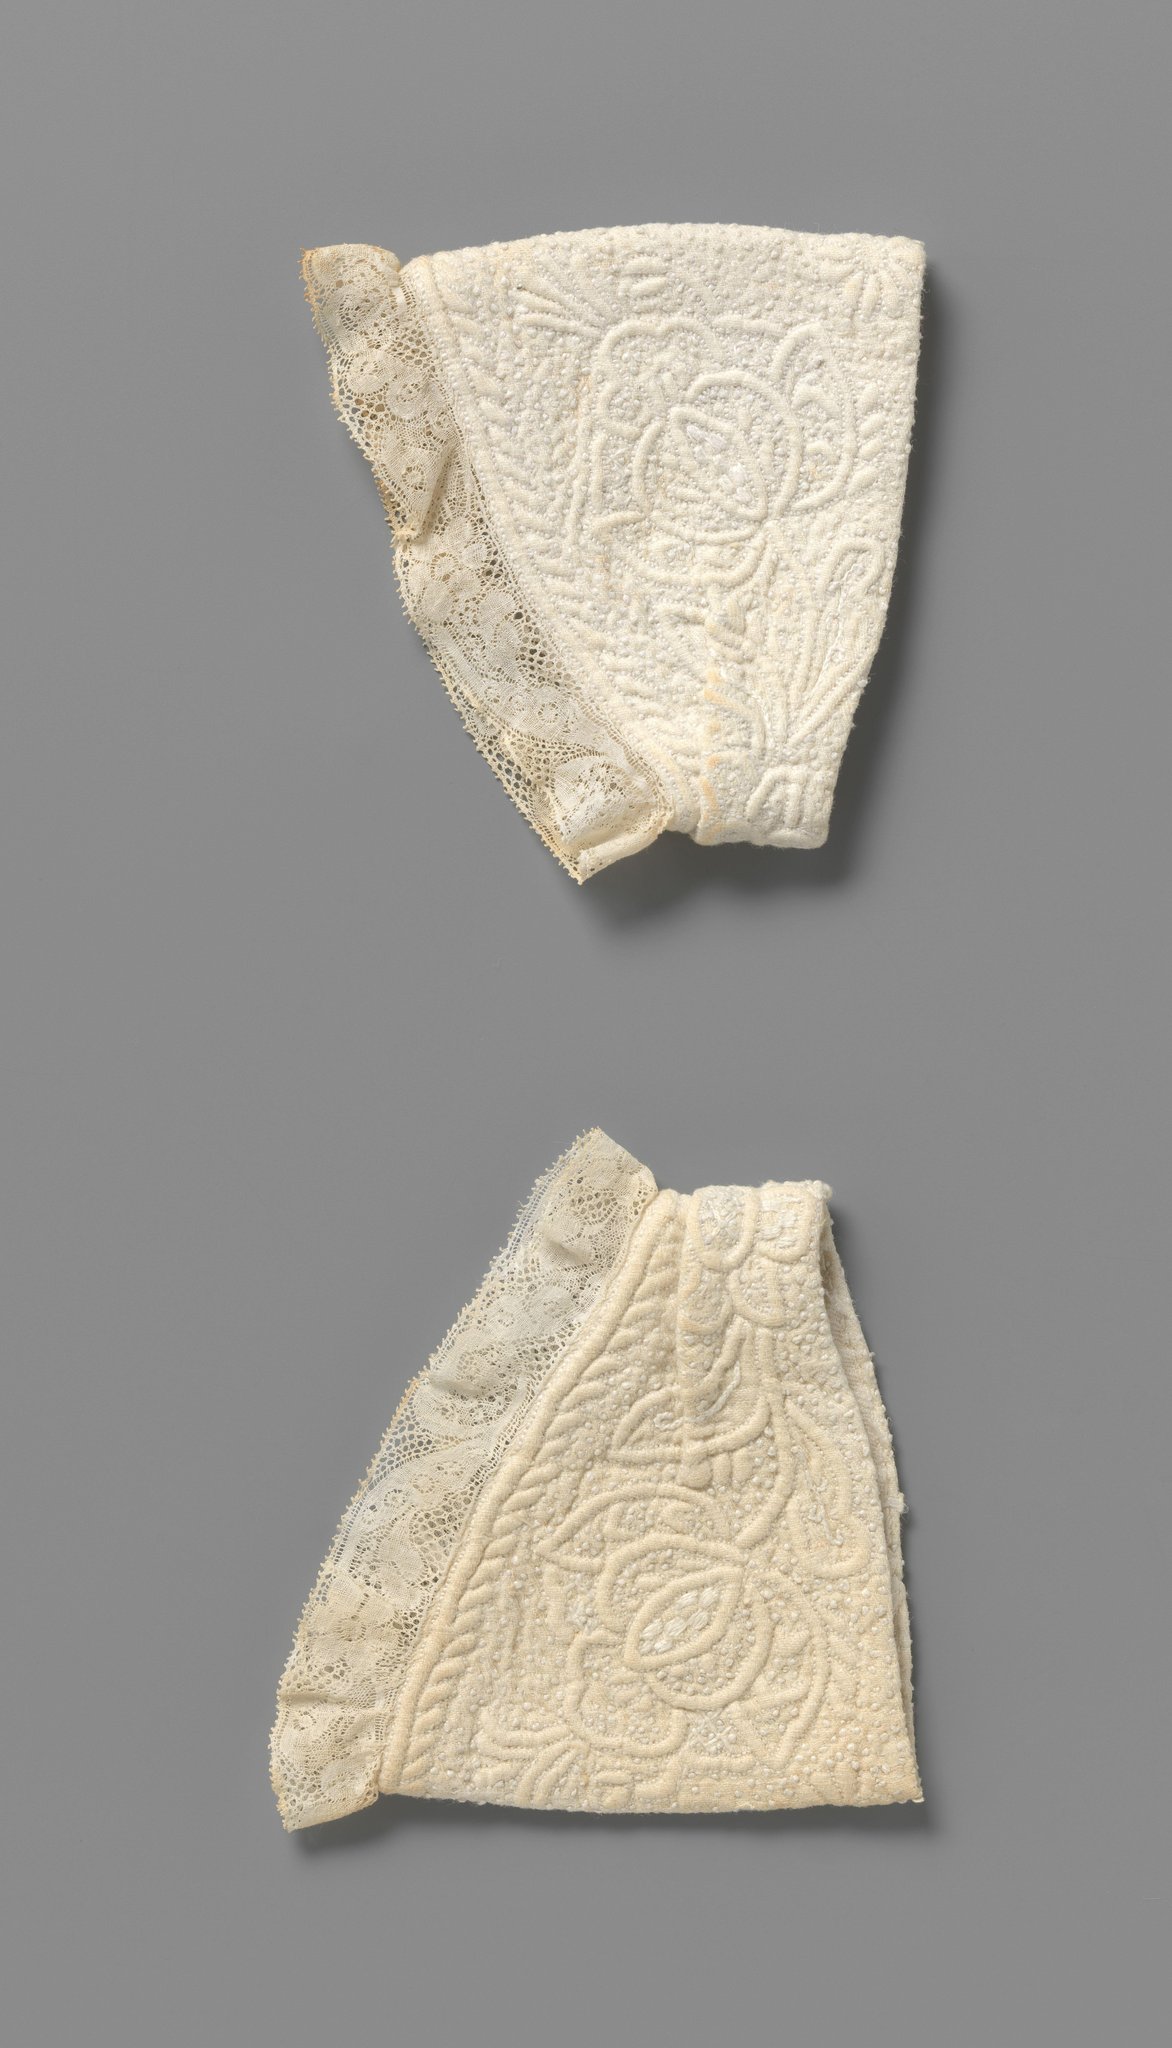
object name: childrenswear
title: Mouw van wit linnen met Zaans stikwerk en Vlaamse kant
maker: Anonymous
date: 1775-1800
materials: linen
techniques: lace, embroidered, quilting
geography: netherlands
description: Rechtermouw van wit linnen met Zaans stikwerk in grote bloemmotieven en afgezet met Vlaamse kant in bloempatroon voor kind.